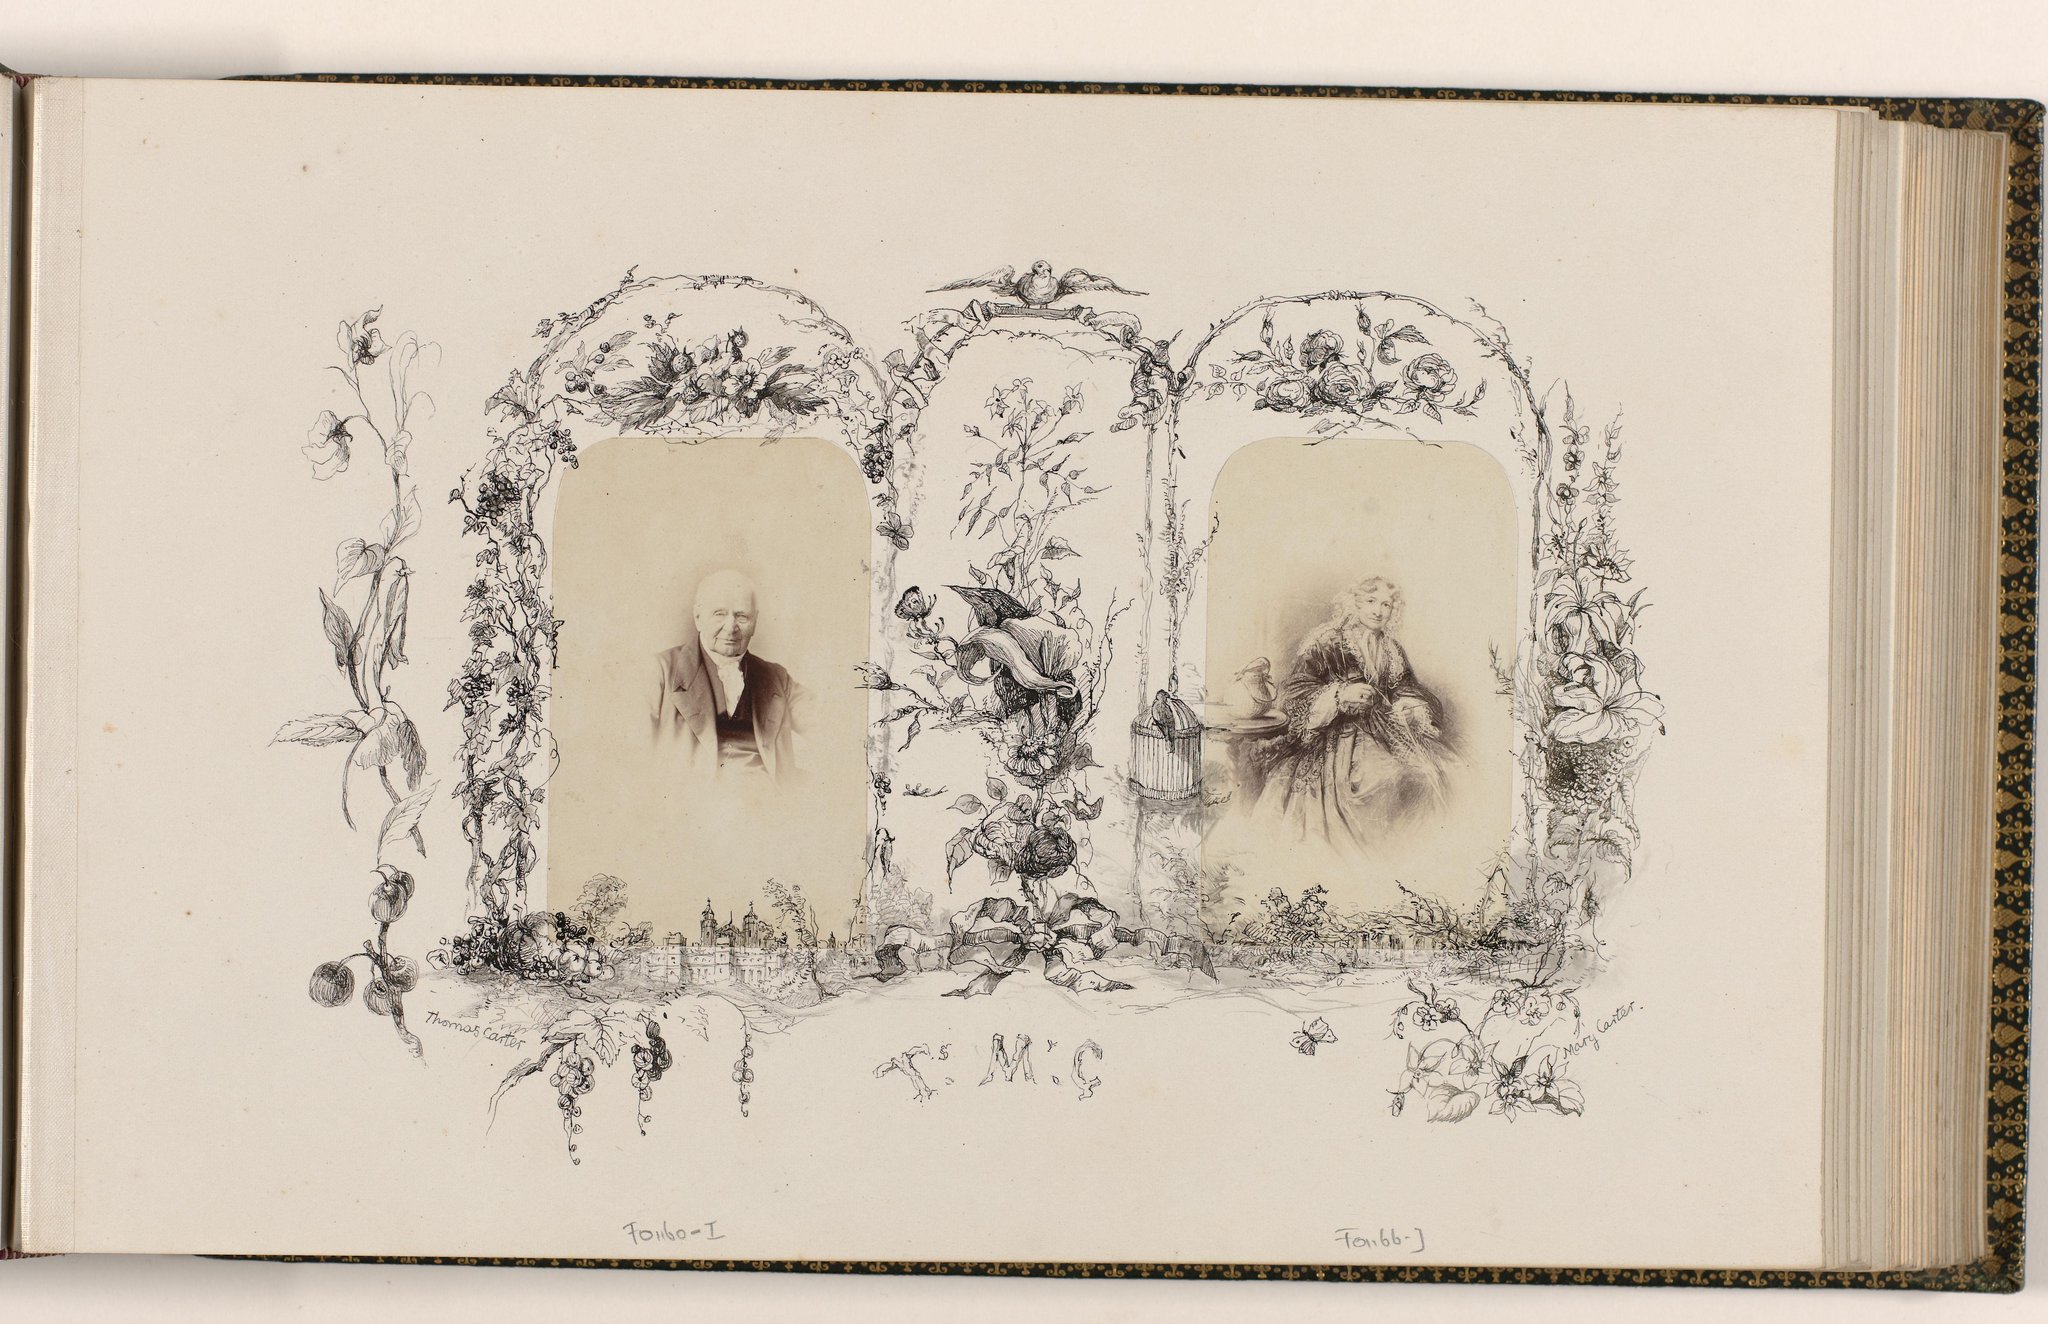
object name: album leaf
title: Portret van Mary Carter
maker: Anonymous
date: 1865-1875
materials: paper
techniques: albumen print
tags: historical persons - bb - woman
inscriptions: inscription: ‘Mary Carter’